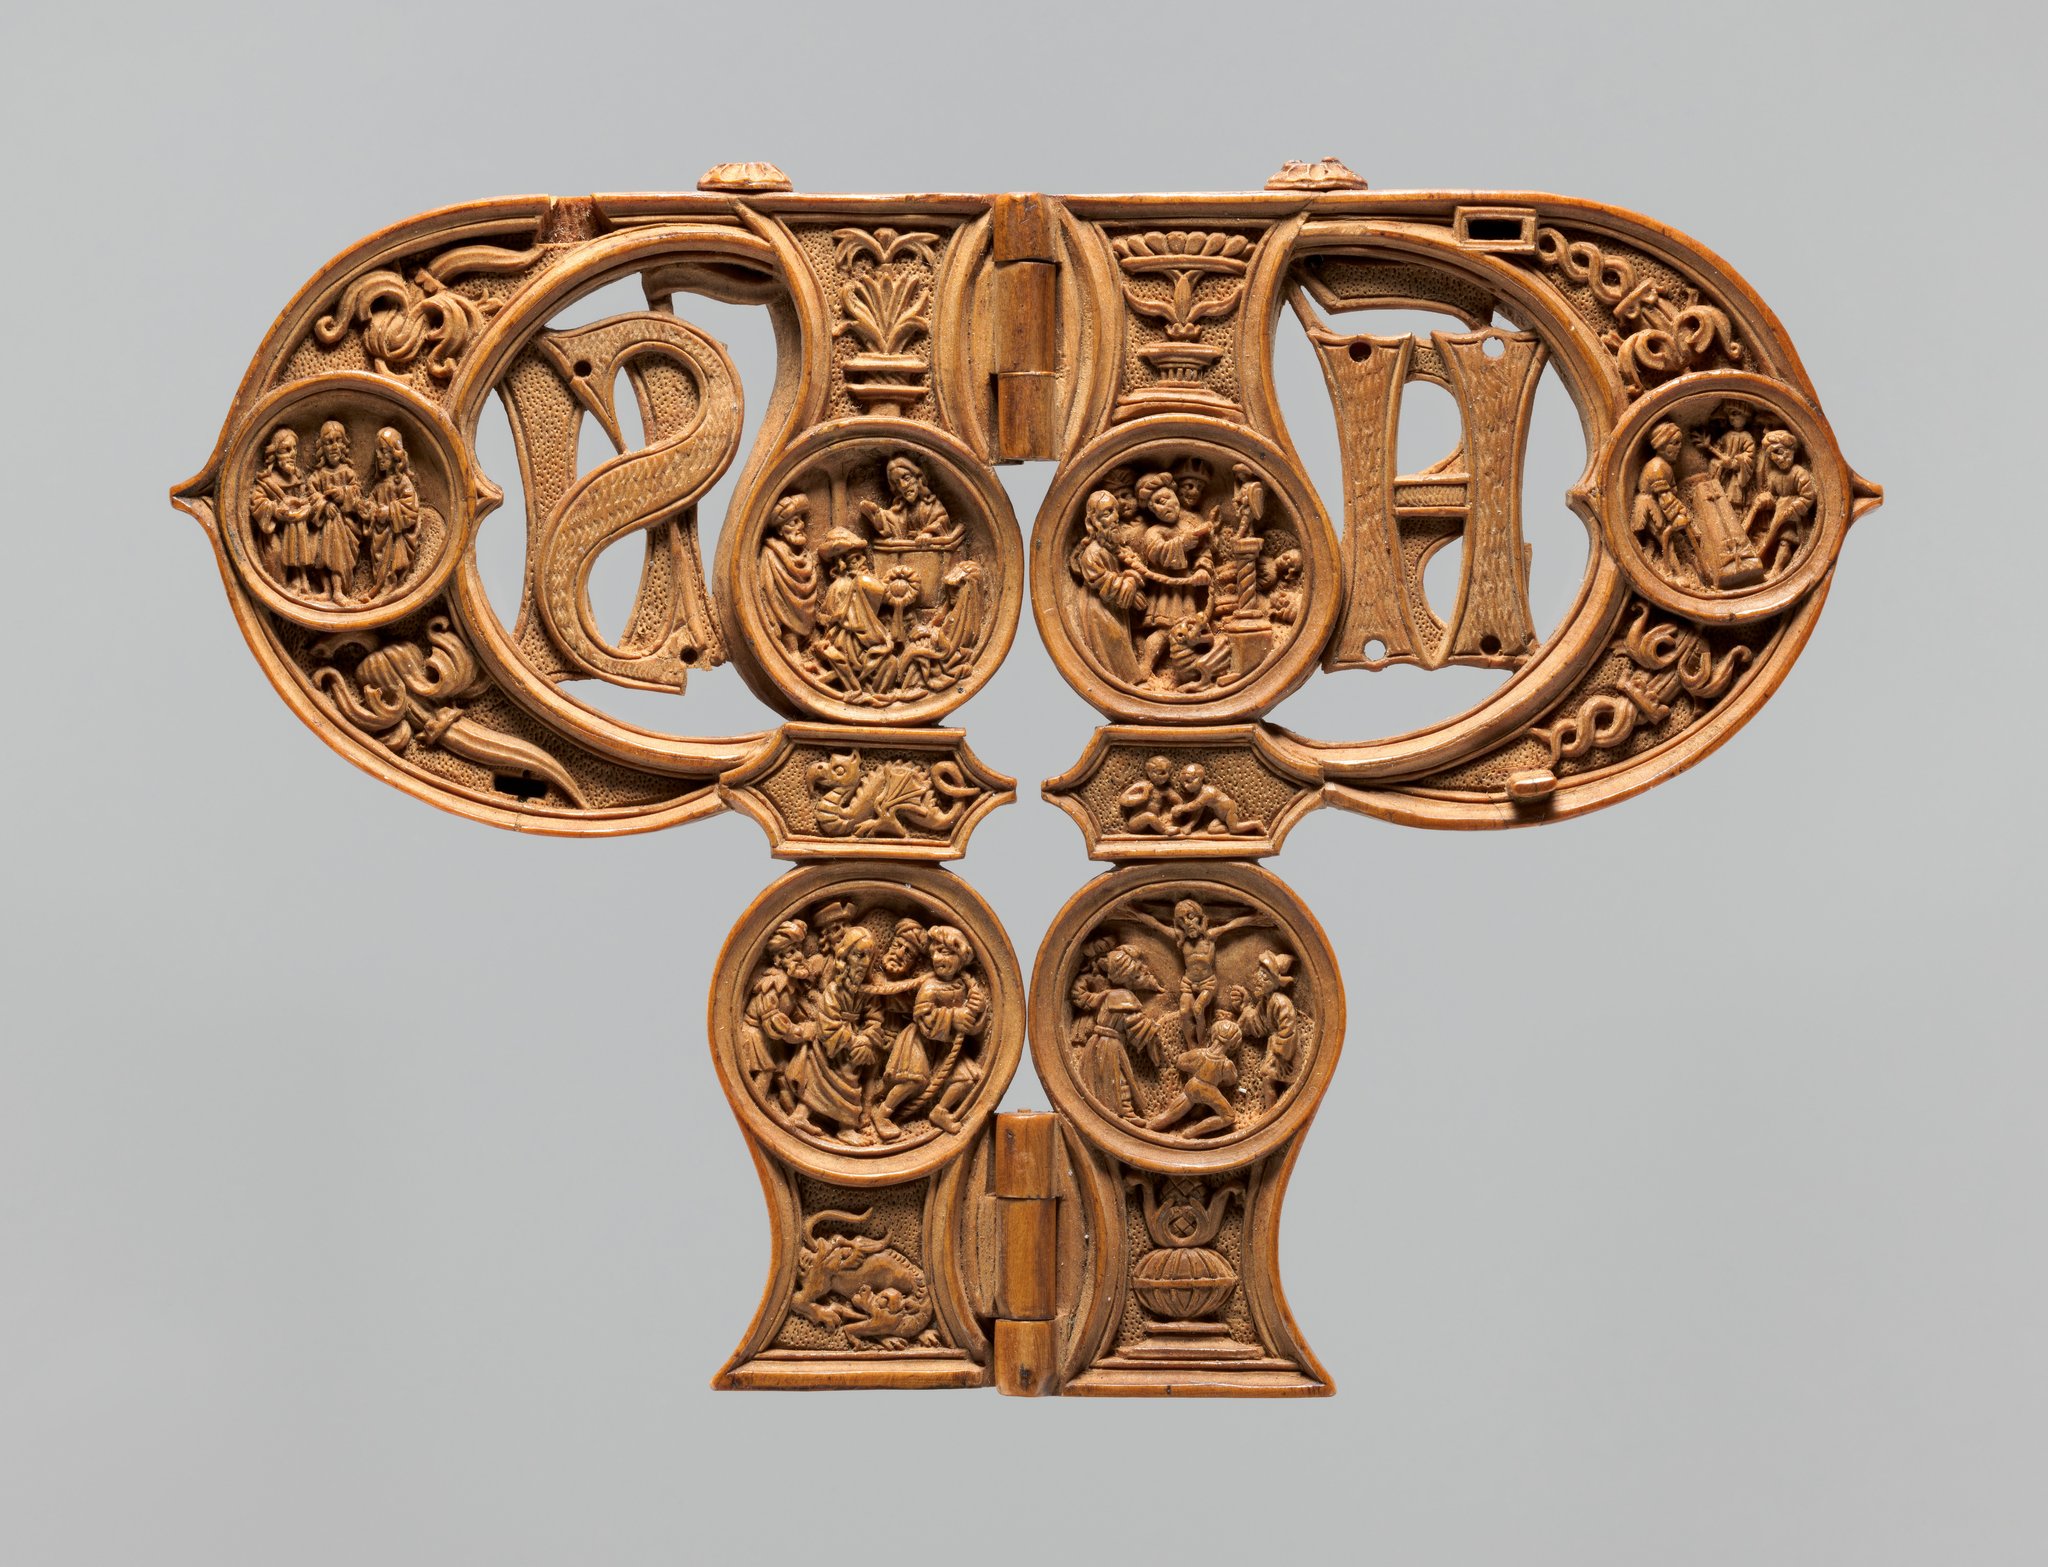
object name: letter p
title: Letter P with the Legend of Saint Philip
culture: dutch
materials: wood, silk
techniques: embroidery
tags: crucifixion,saints